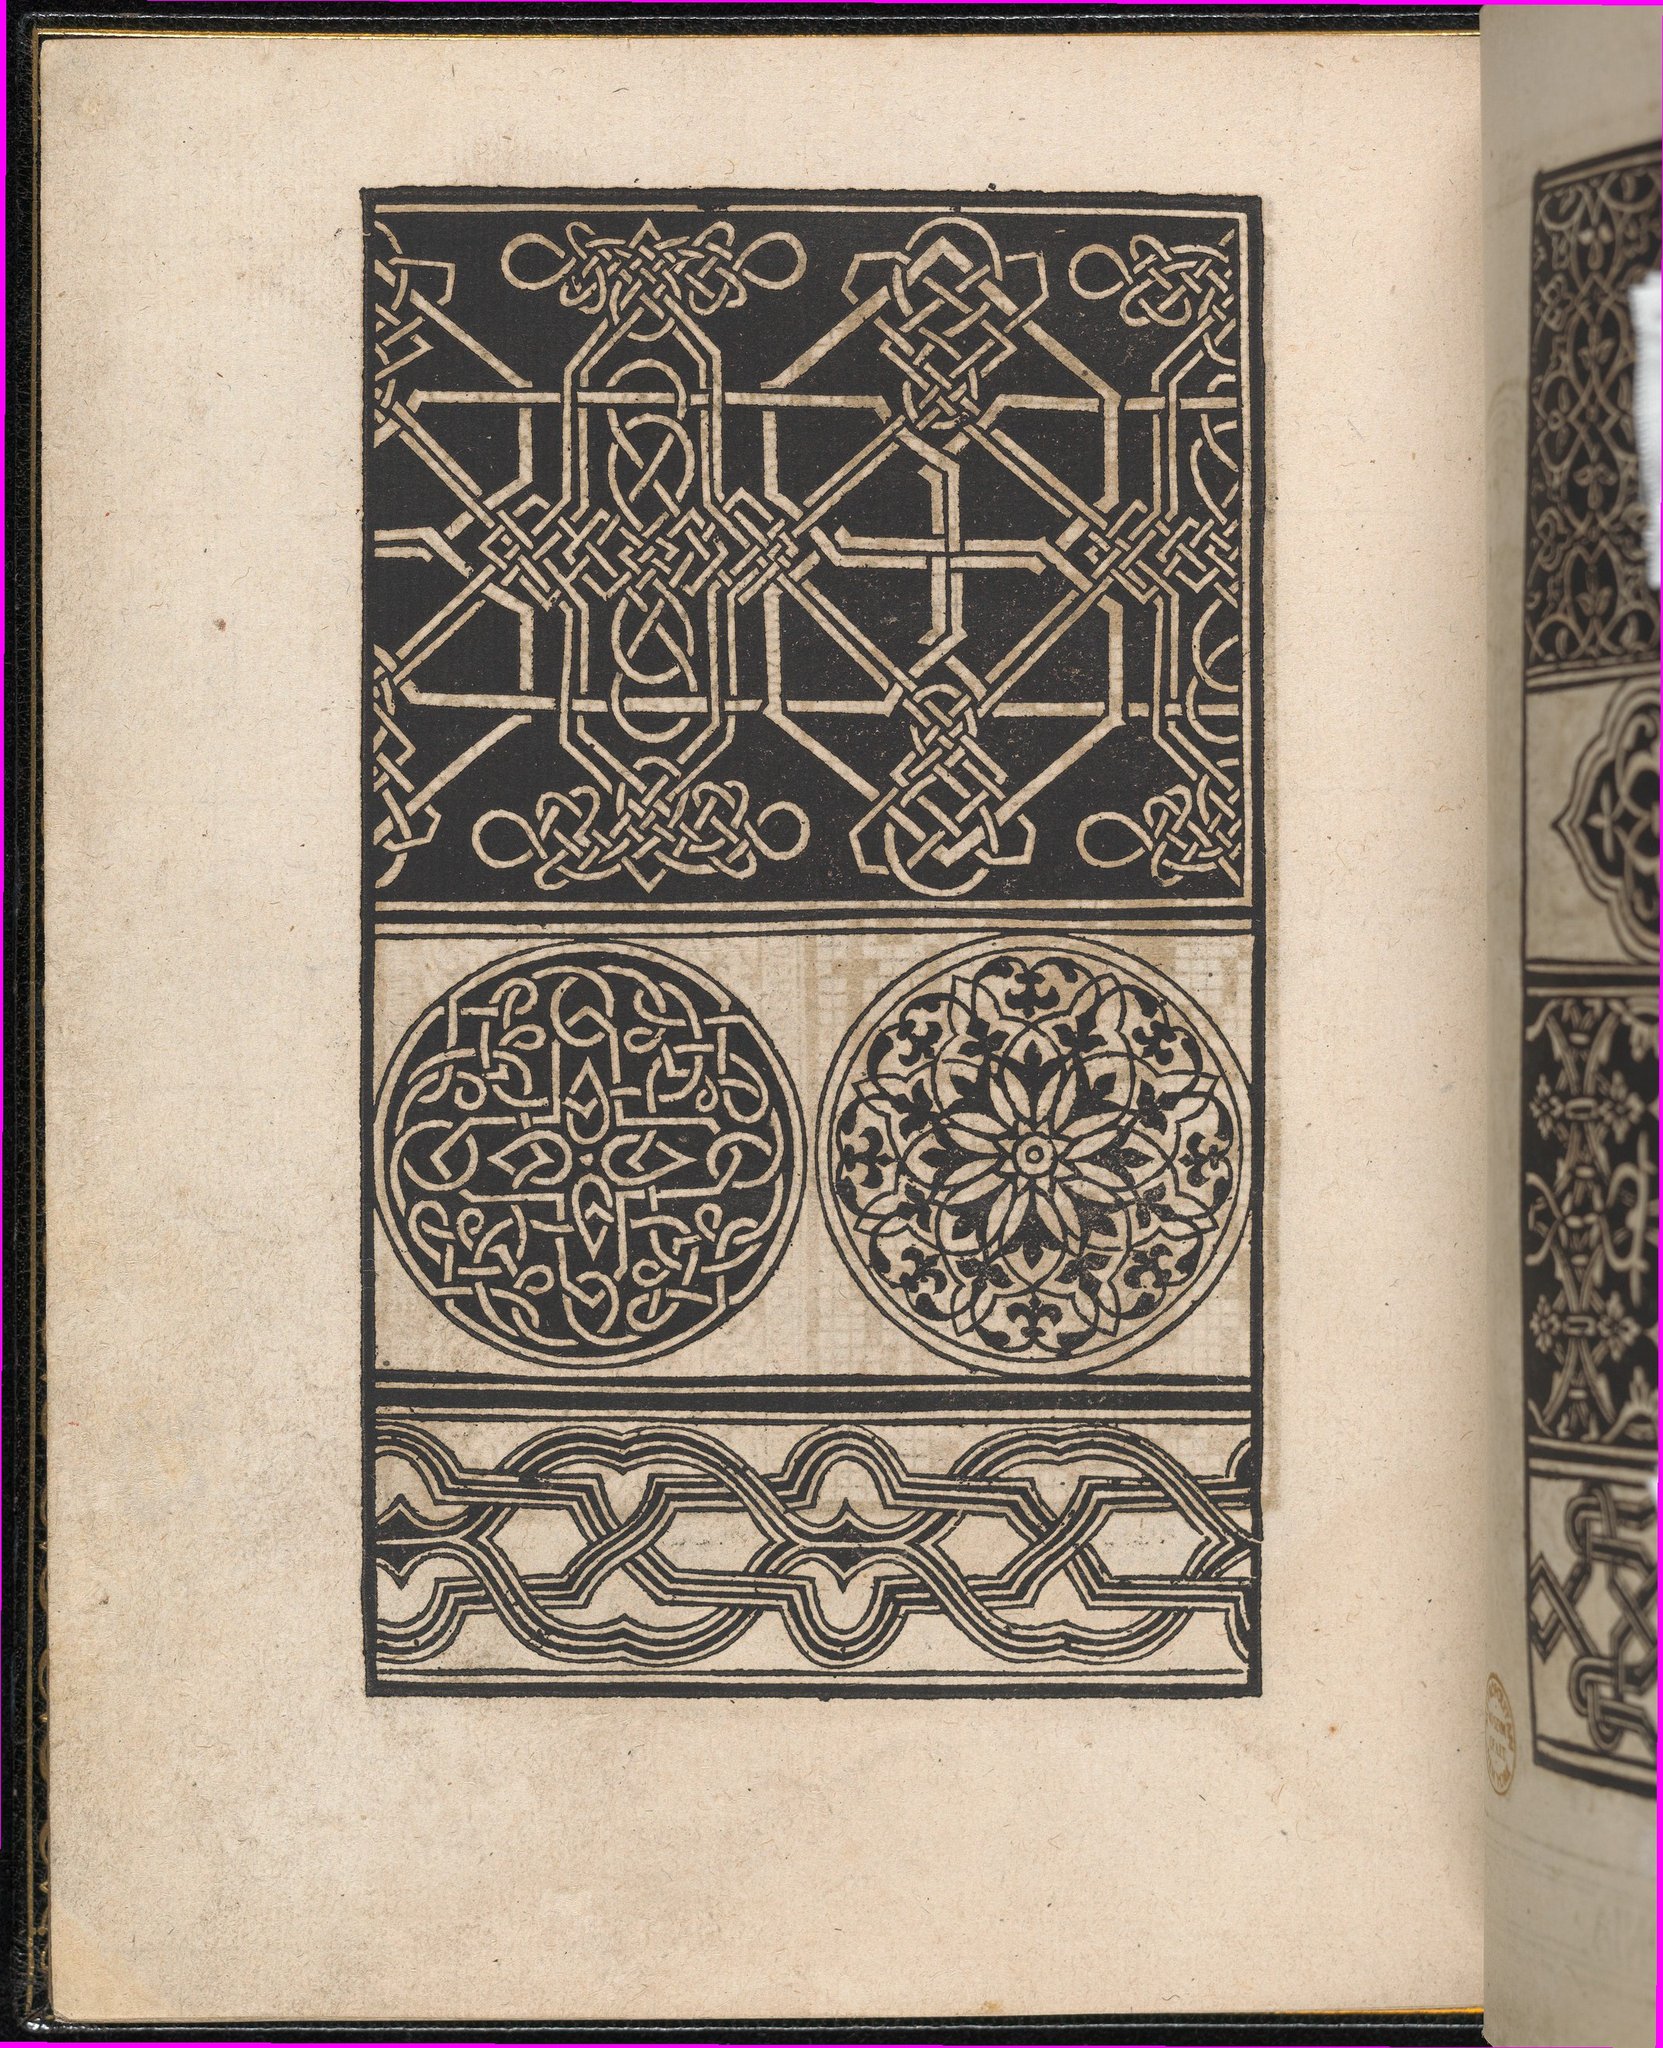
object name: book print ornament architecture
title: Page from Ein new kunstlich Modelbuch...(Page 50v)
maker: peter quentel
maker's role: publisher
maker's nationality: german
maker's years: 1500-1550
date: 1544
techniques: woodcut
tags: ornament